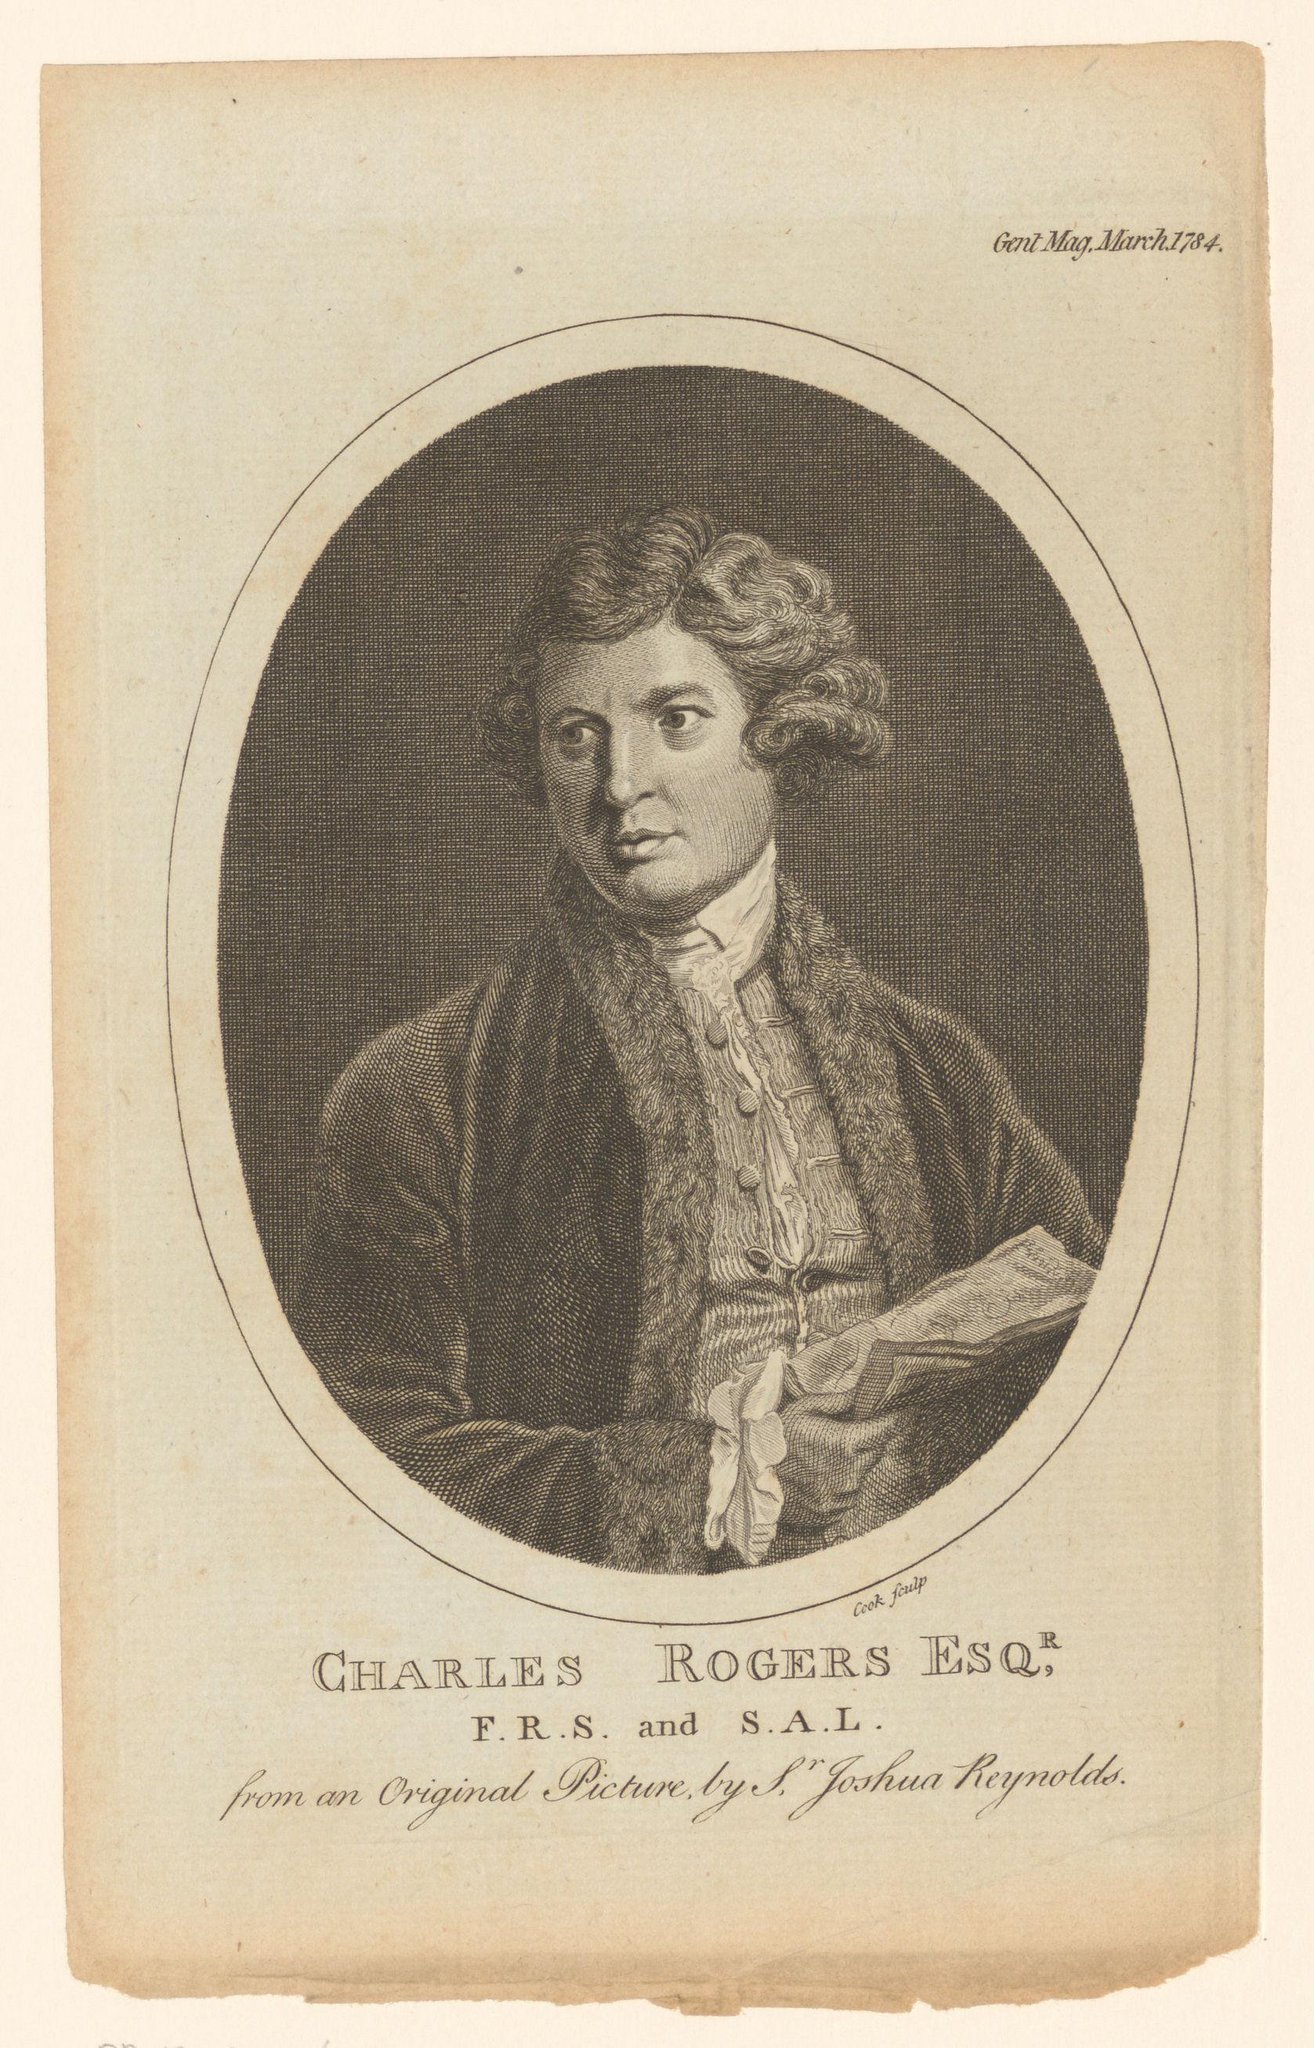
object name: print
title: Portret van Charles Rogers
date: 1784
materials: paper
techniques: engraving, etching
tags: historical persons, art collector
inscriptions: collector's mark: Lugt 2228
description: Prent is gebruikt in: The gentlemans magazine and historical chronicle 54 (1784), nr. 1, maart 1784.